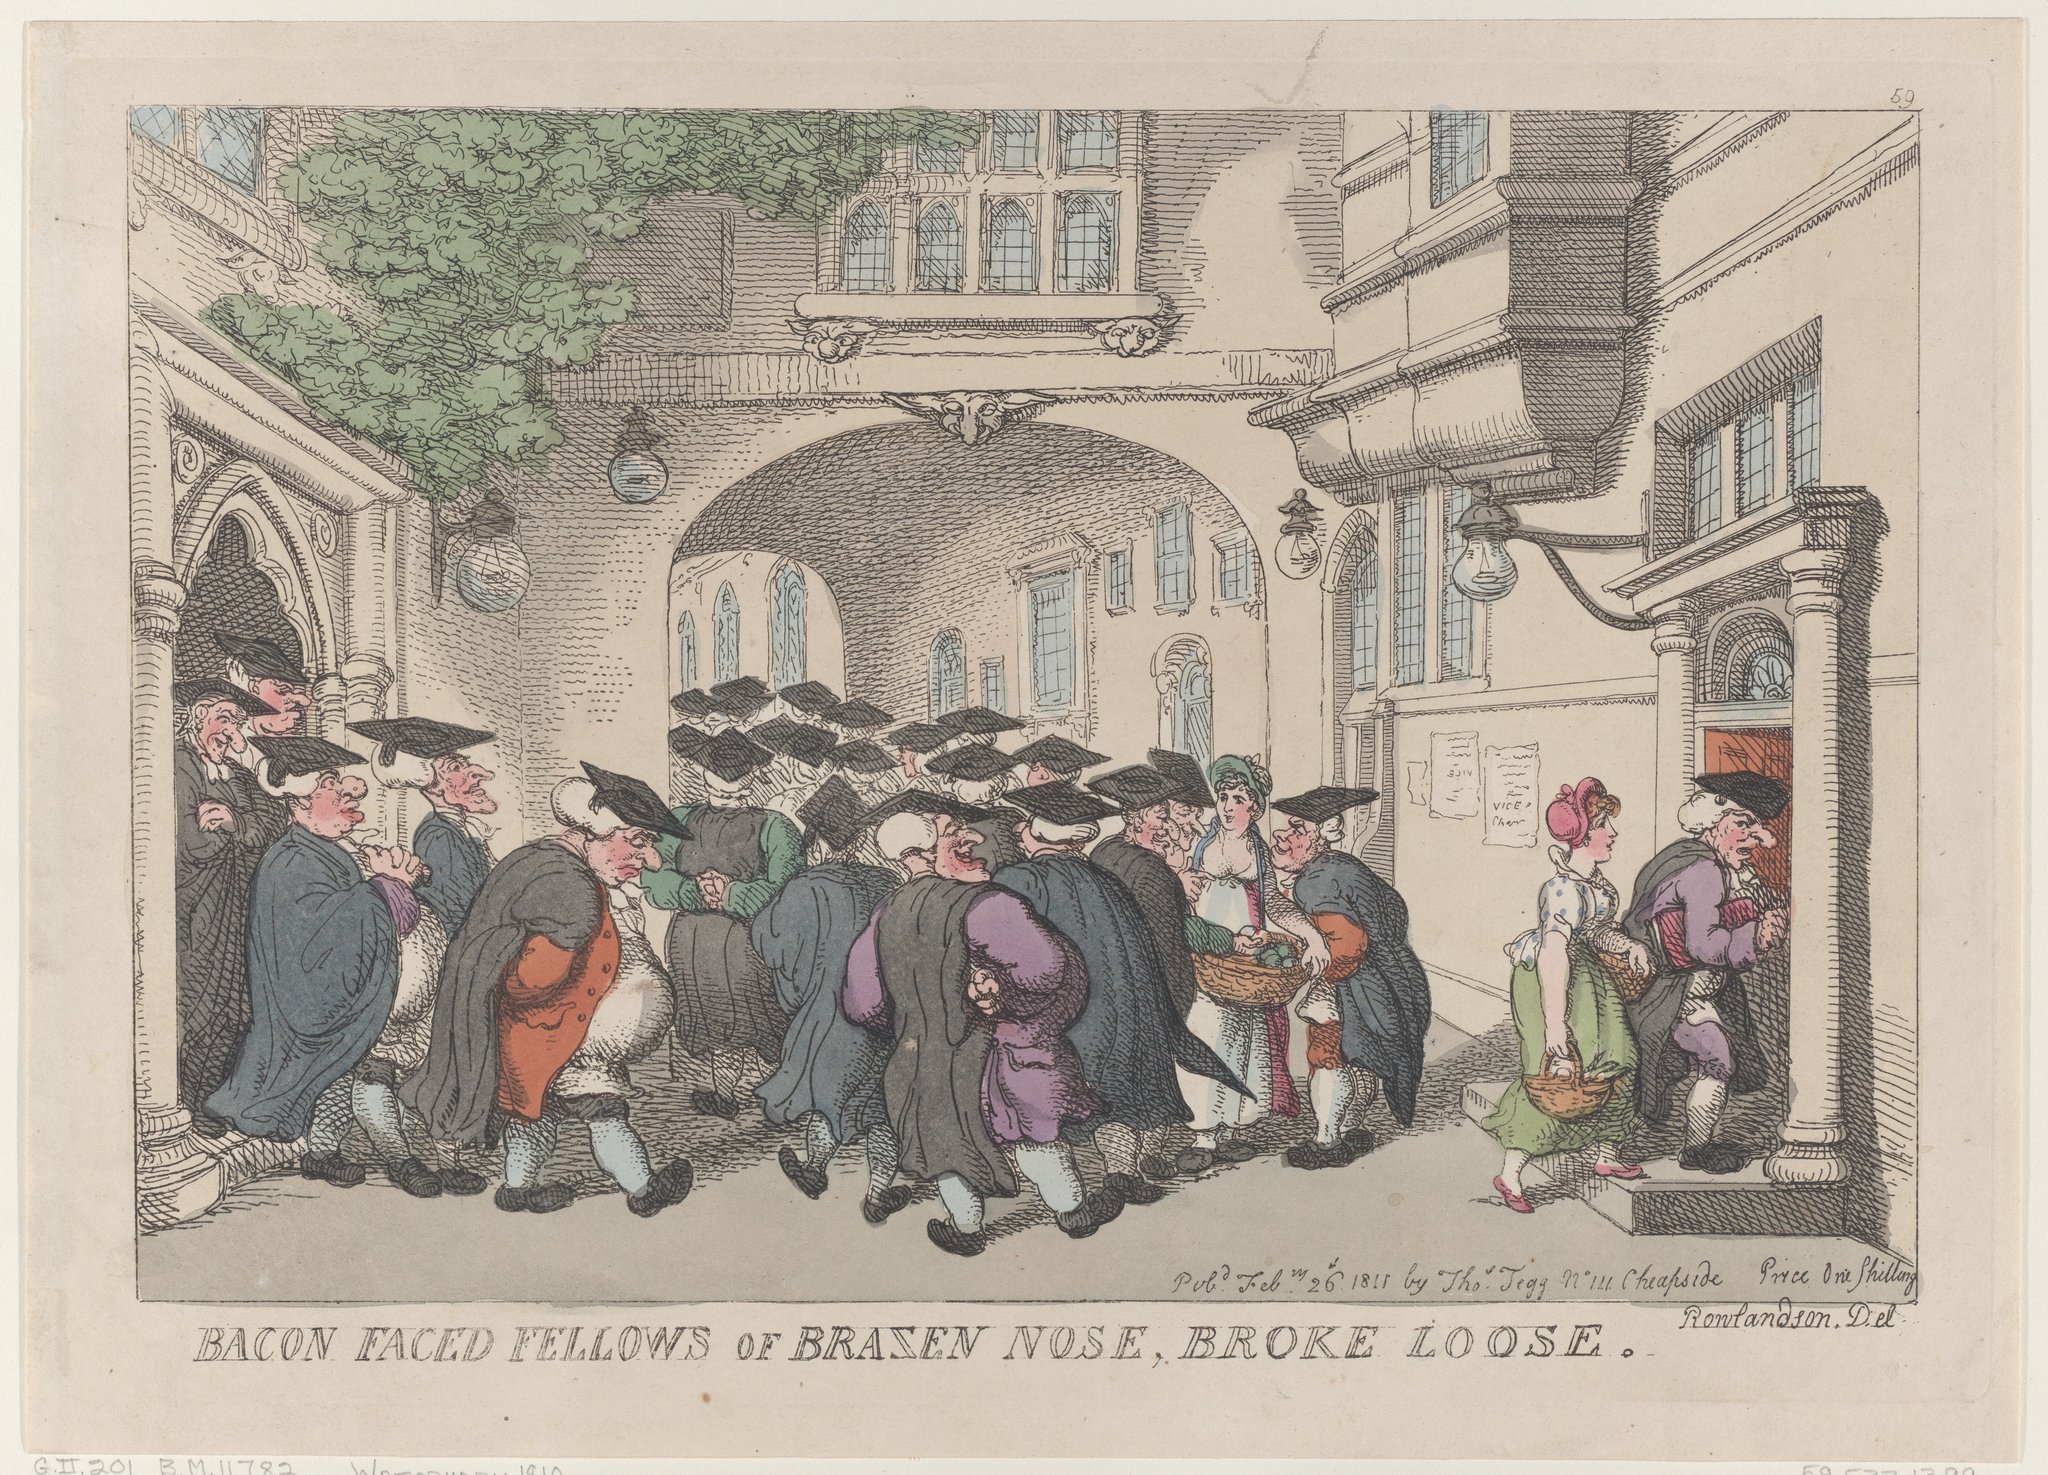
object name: print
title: Bacon Faced Fellows of Brazen Nose, Broke Loose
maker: thomas rowlandson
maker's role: artist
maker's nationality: british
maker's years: 1757-1827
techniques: etching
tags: satire,men,women